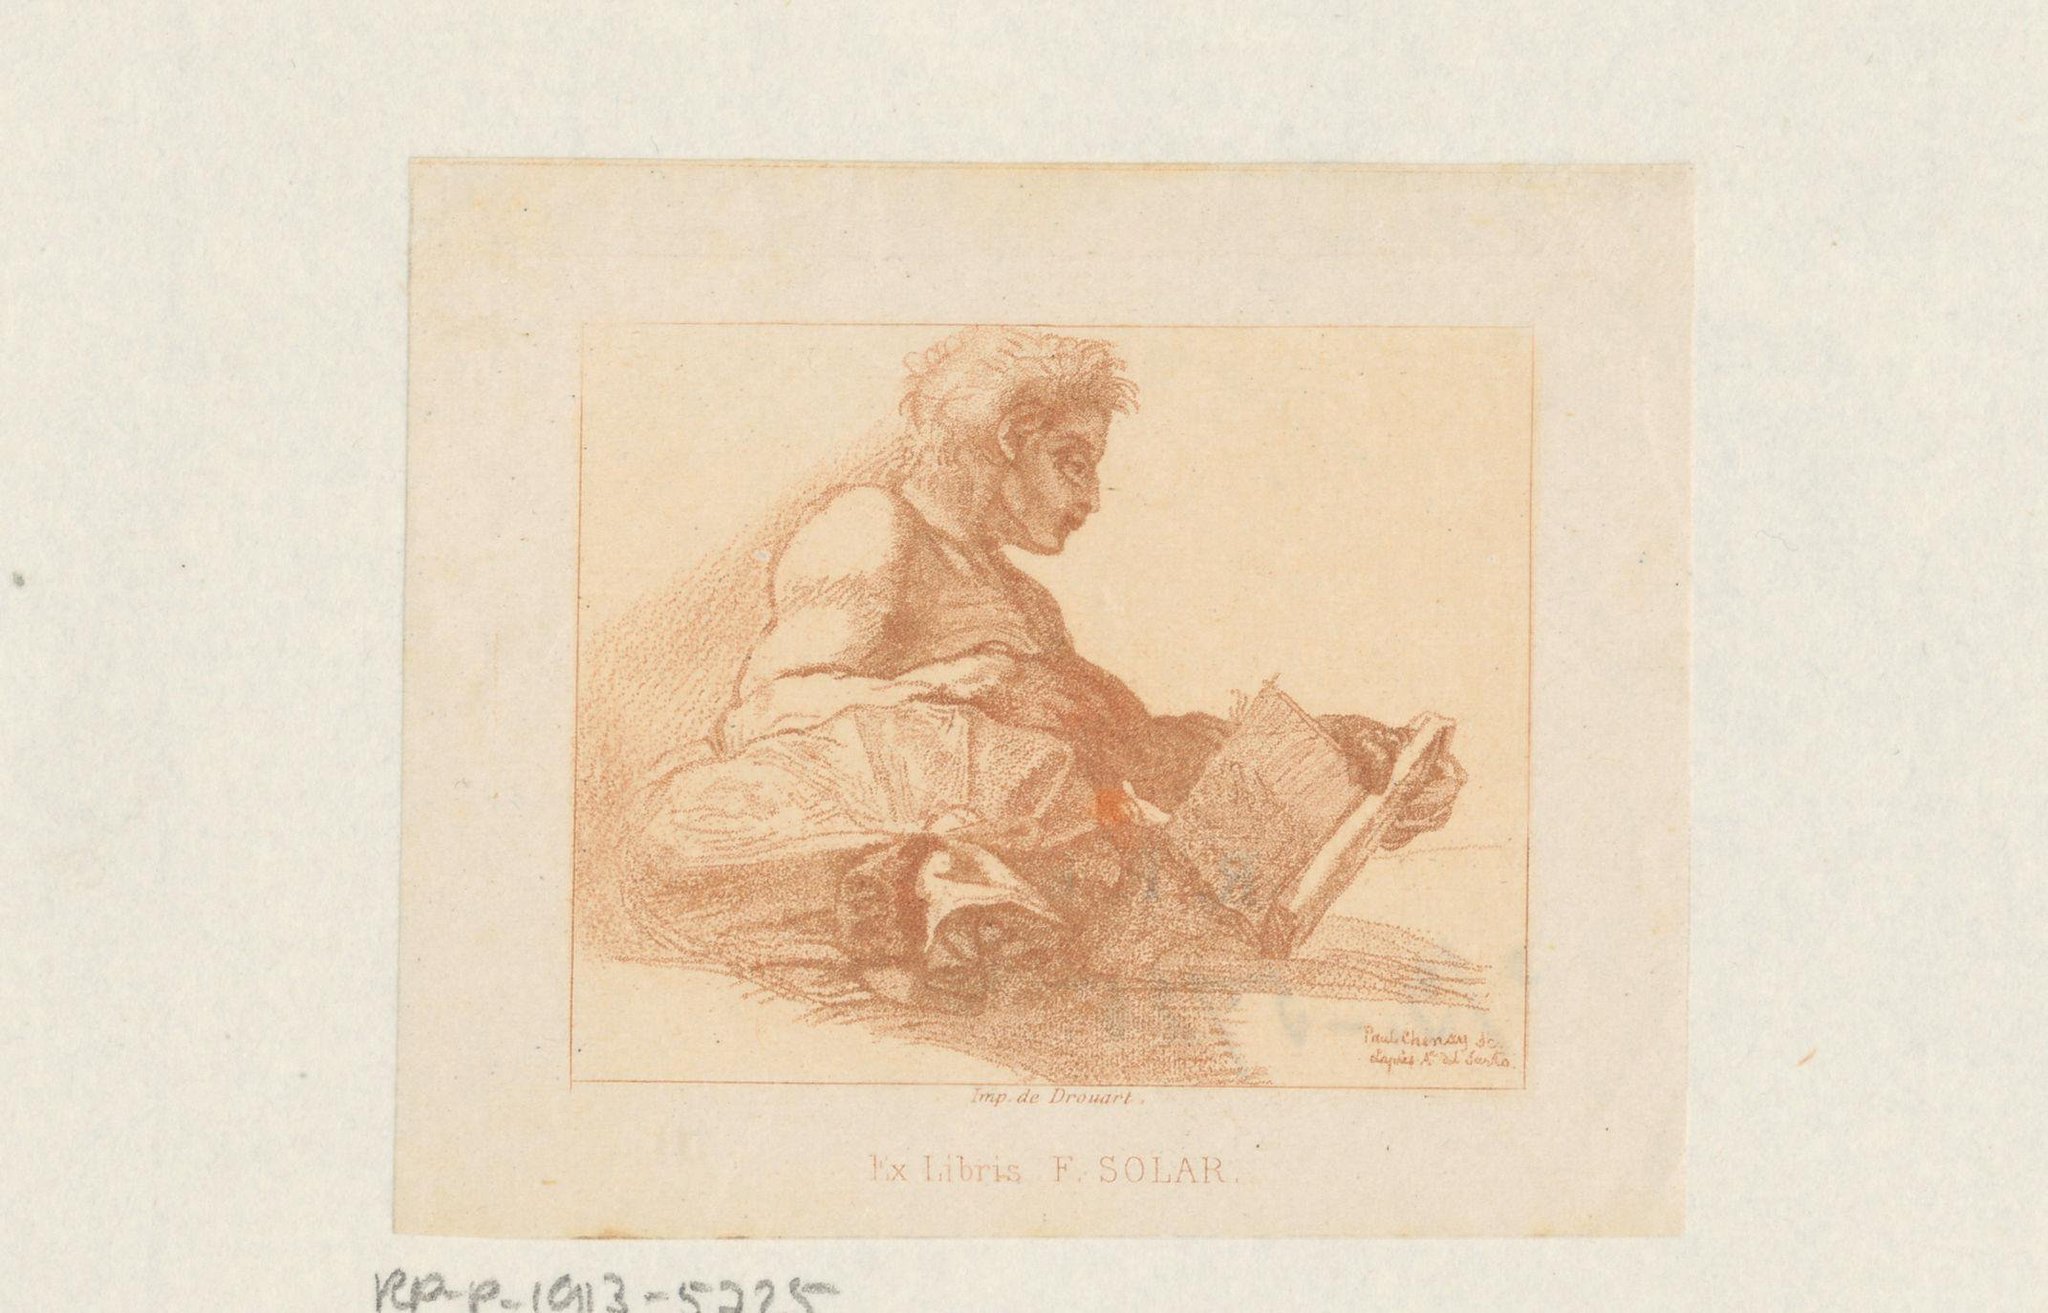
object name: bookplate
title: Ex libris F. Solar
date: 1828-1870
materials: paper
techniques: etching, intaglio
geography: france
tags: sitting figure, book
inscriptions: collector's mark: Lugt 2760, collector's mark: Lugt 2233